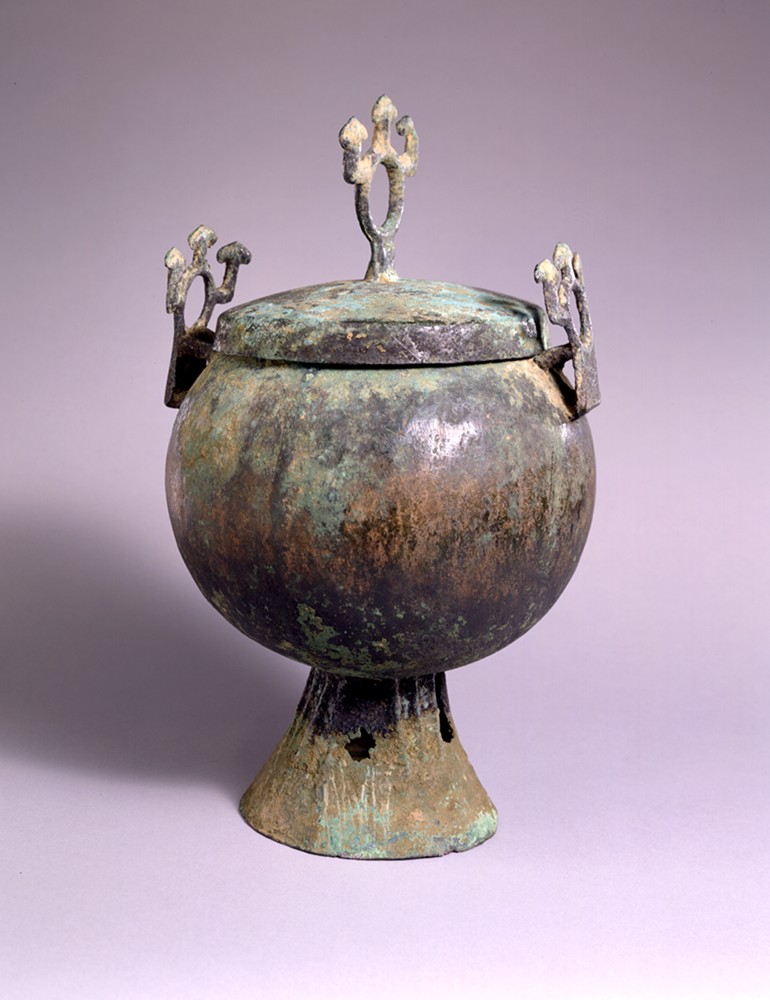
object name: cauldron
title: Cauldron with lid (Fu)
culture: north chinese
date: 101-400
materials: bronze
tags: cauldrons